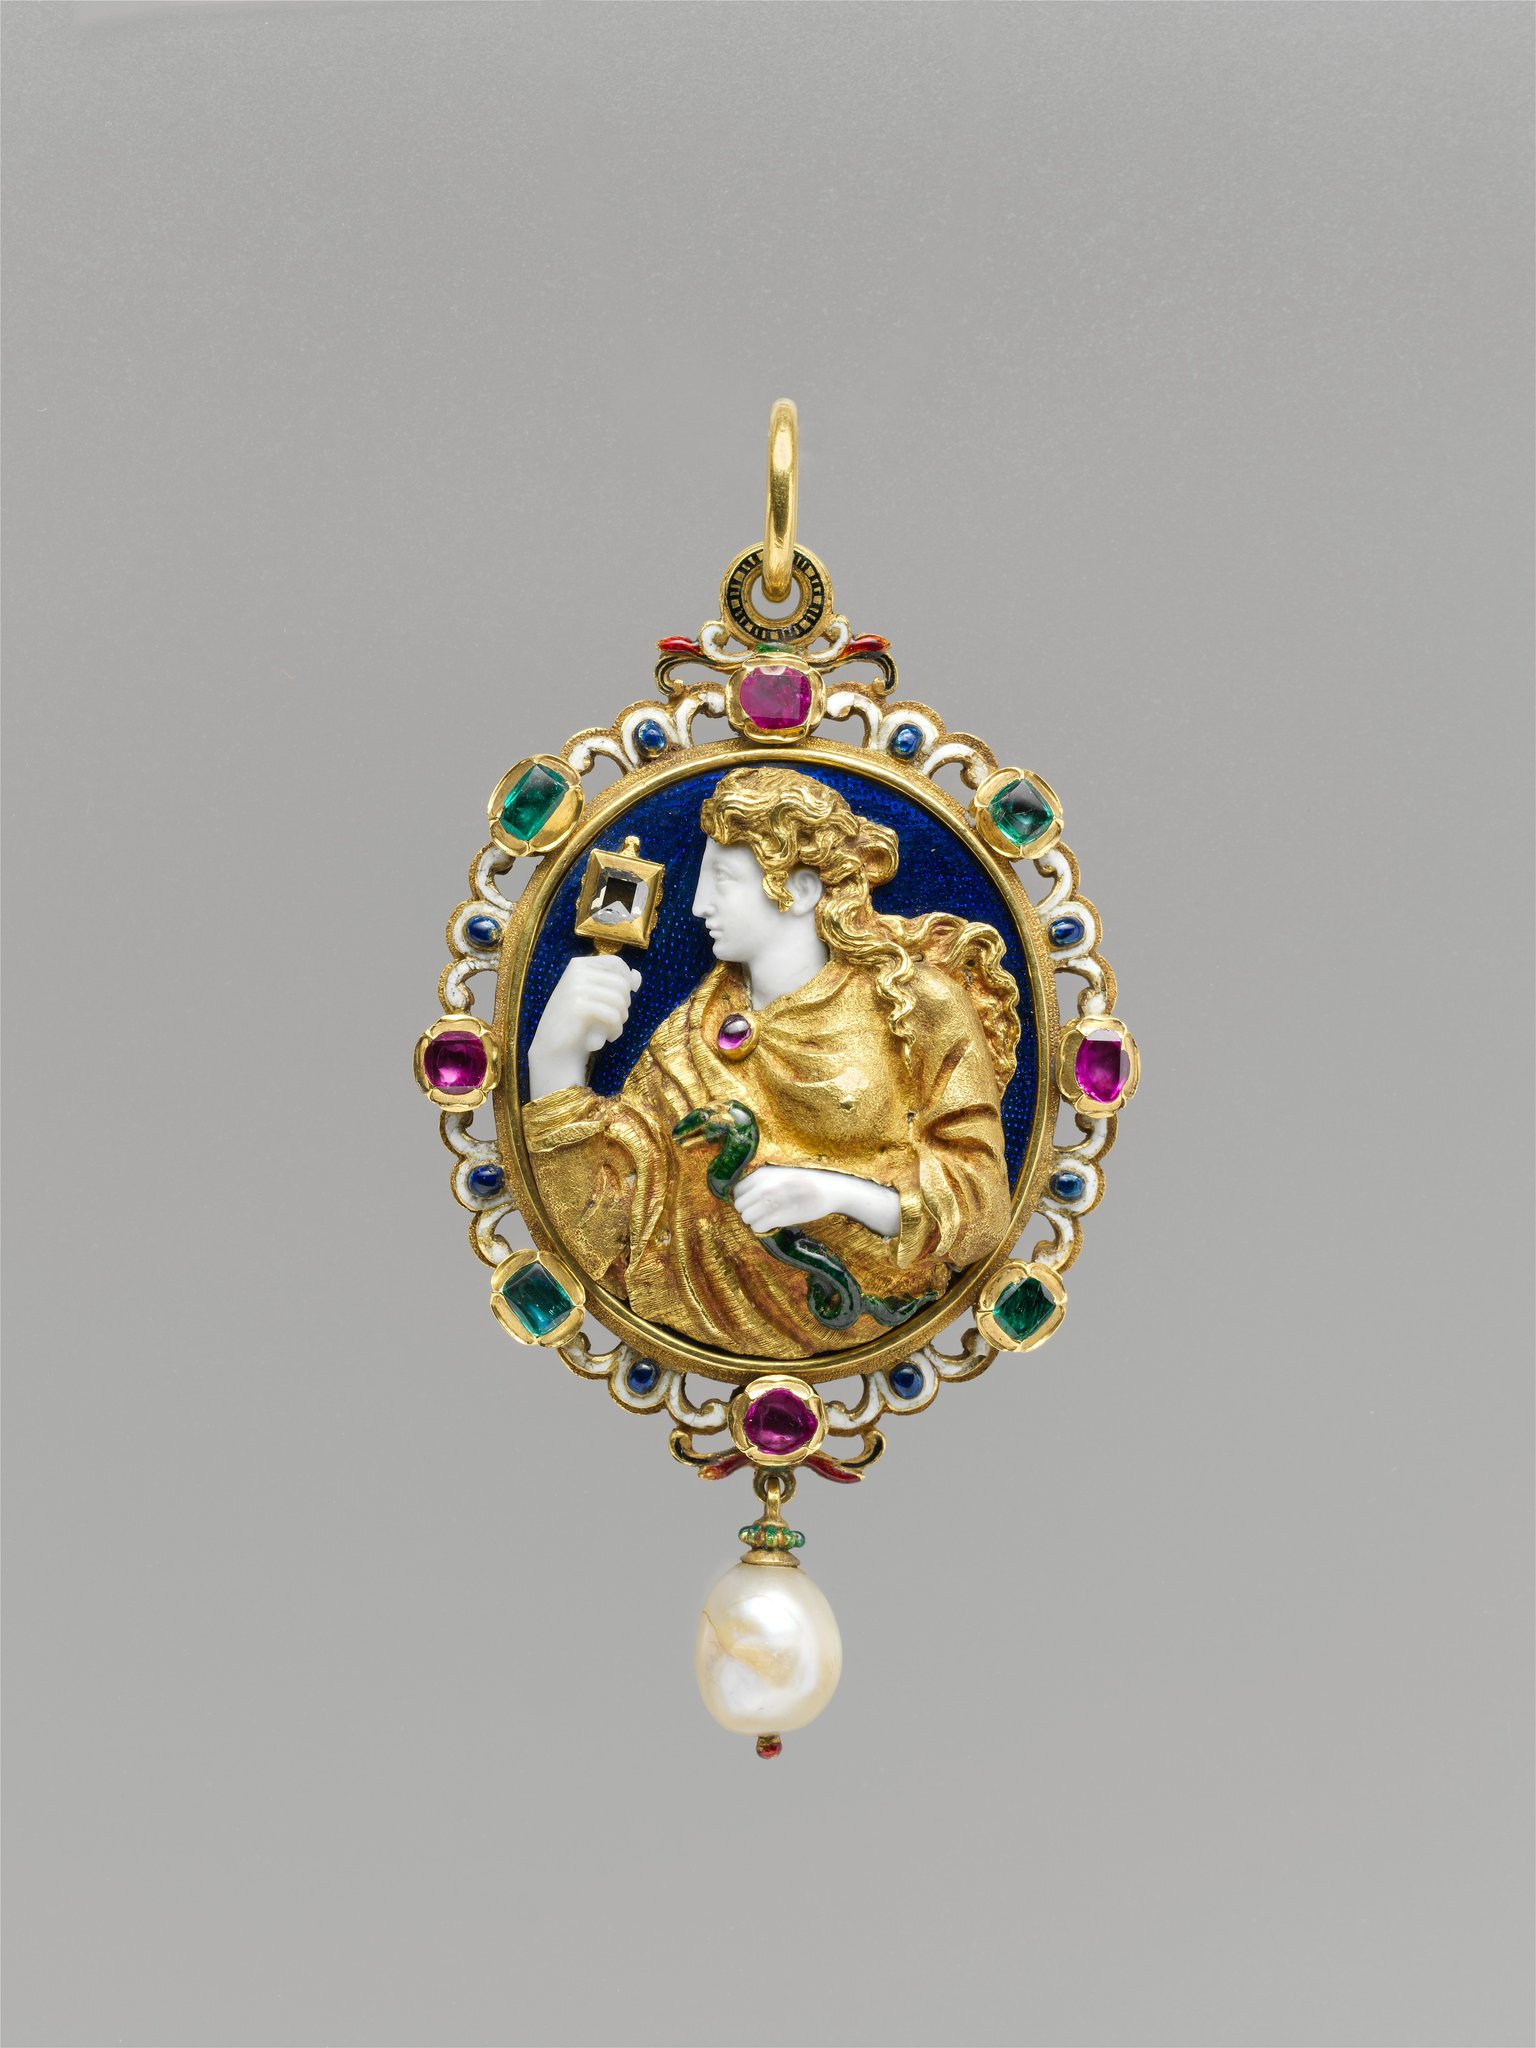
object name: pendant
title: Prudence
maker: etienne delaune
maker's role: artist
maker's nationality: french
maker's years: 1518-1583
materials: stone, diamond, gemstone, enamel, gold, pearl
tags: women,snakes